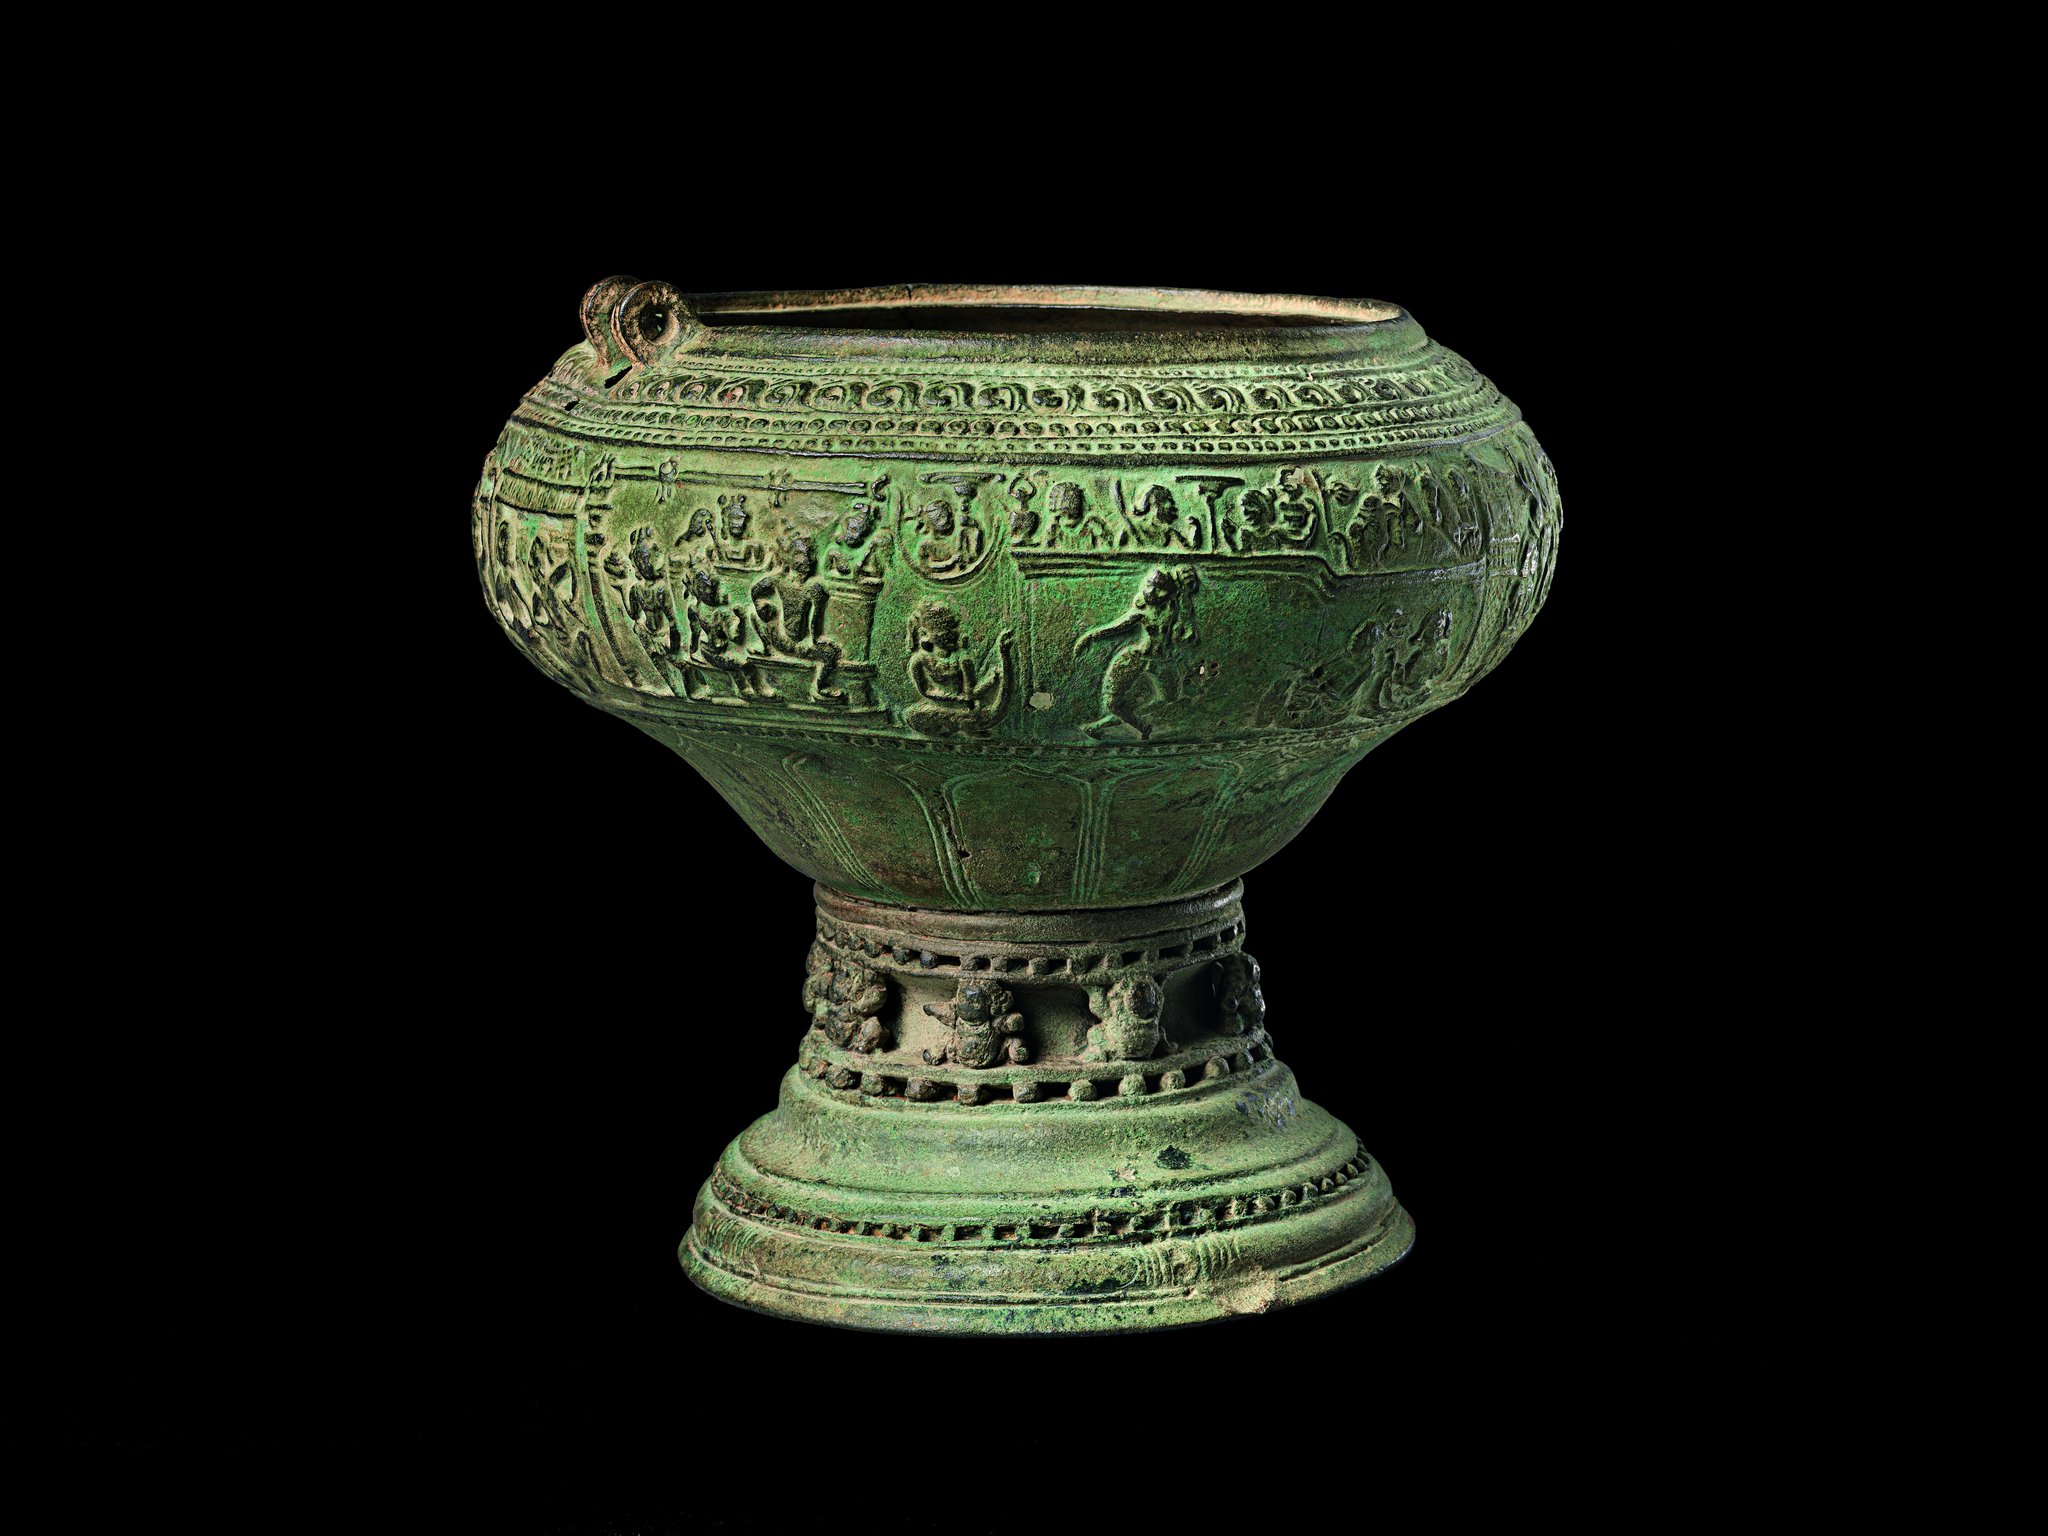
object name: censer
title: Footed Bowl with Scenes from the Gauttila Jataka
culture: indian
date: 401-600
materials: copper alloy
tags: human figures,later andhra,elephants,horses,dancers